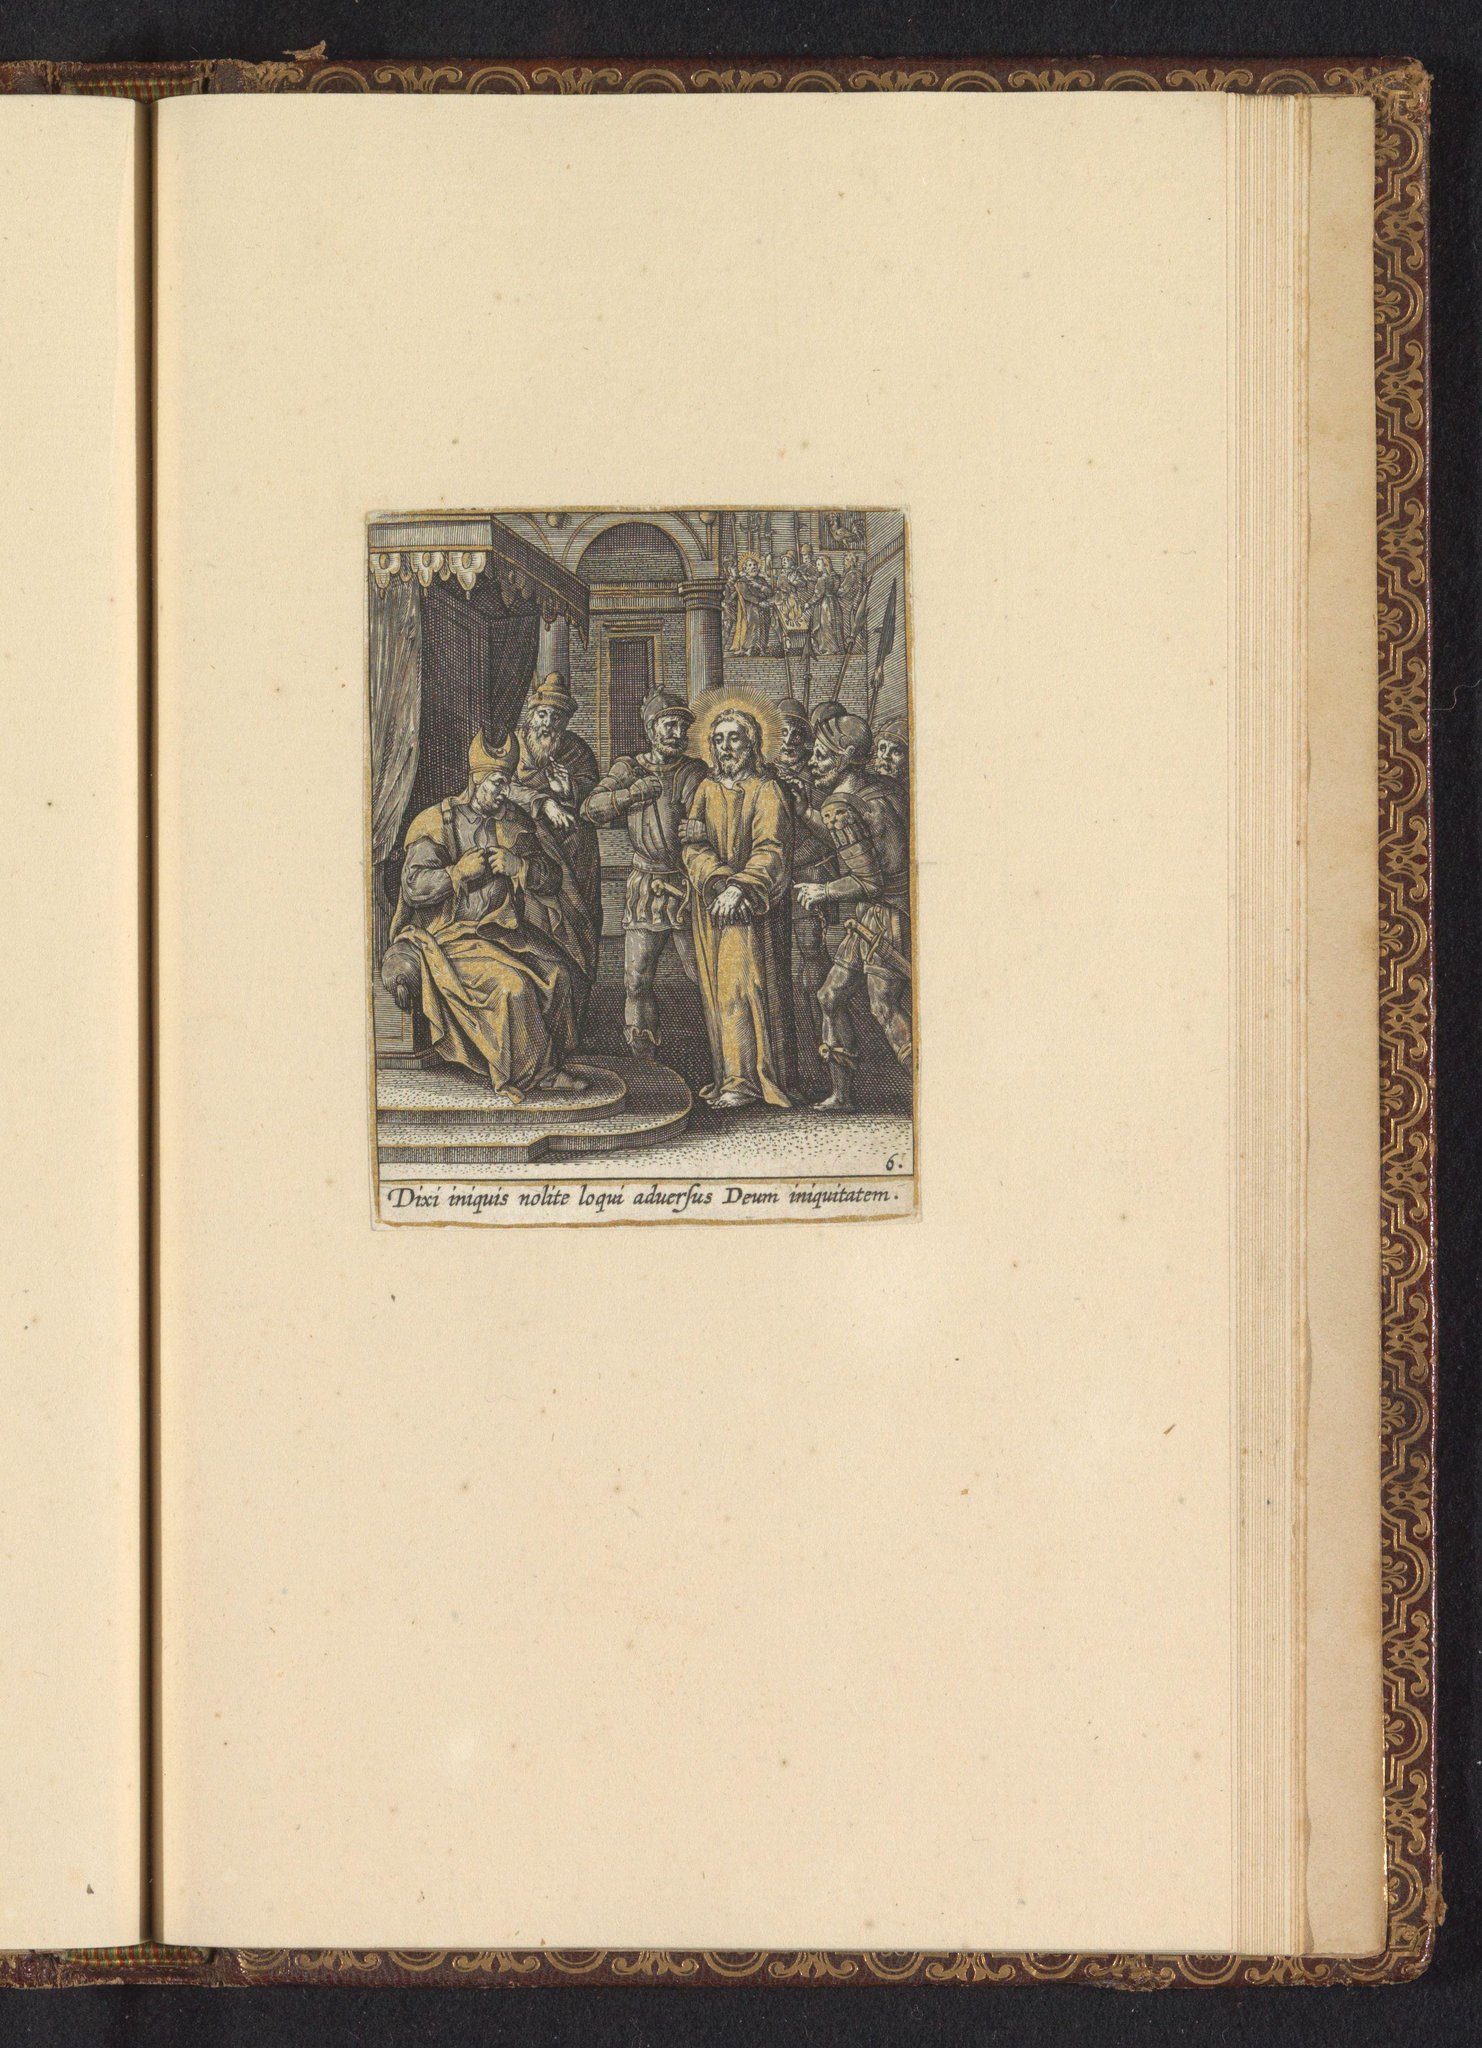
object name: print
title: Christus voor Kajafas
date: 1580-1590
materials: gold, paper, silver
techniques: engraving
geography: antwerp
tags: christ before the sanhedrin with caiaphas as high priest, and possibly annas; maybe a soldier about to strike christ because he keeps silent (matthew 26:57-66; mark 14:53-64; luke 22:54, 22:66-71)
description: Christus voor Kajafas. Onderdeel van de prentserie over de passie van Christus: Passio et resurrectio D.N. Iesu Christi. Edita et excusa ab Ad. Collaert. In prentalbum met twee reeksen van respectievelijk 34 en 24 gravures met scènes uit het leven en het lijdensverhaal van Christus.